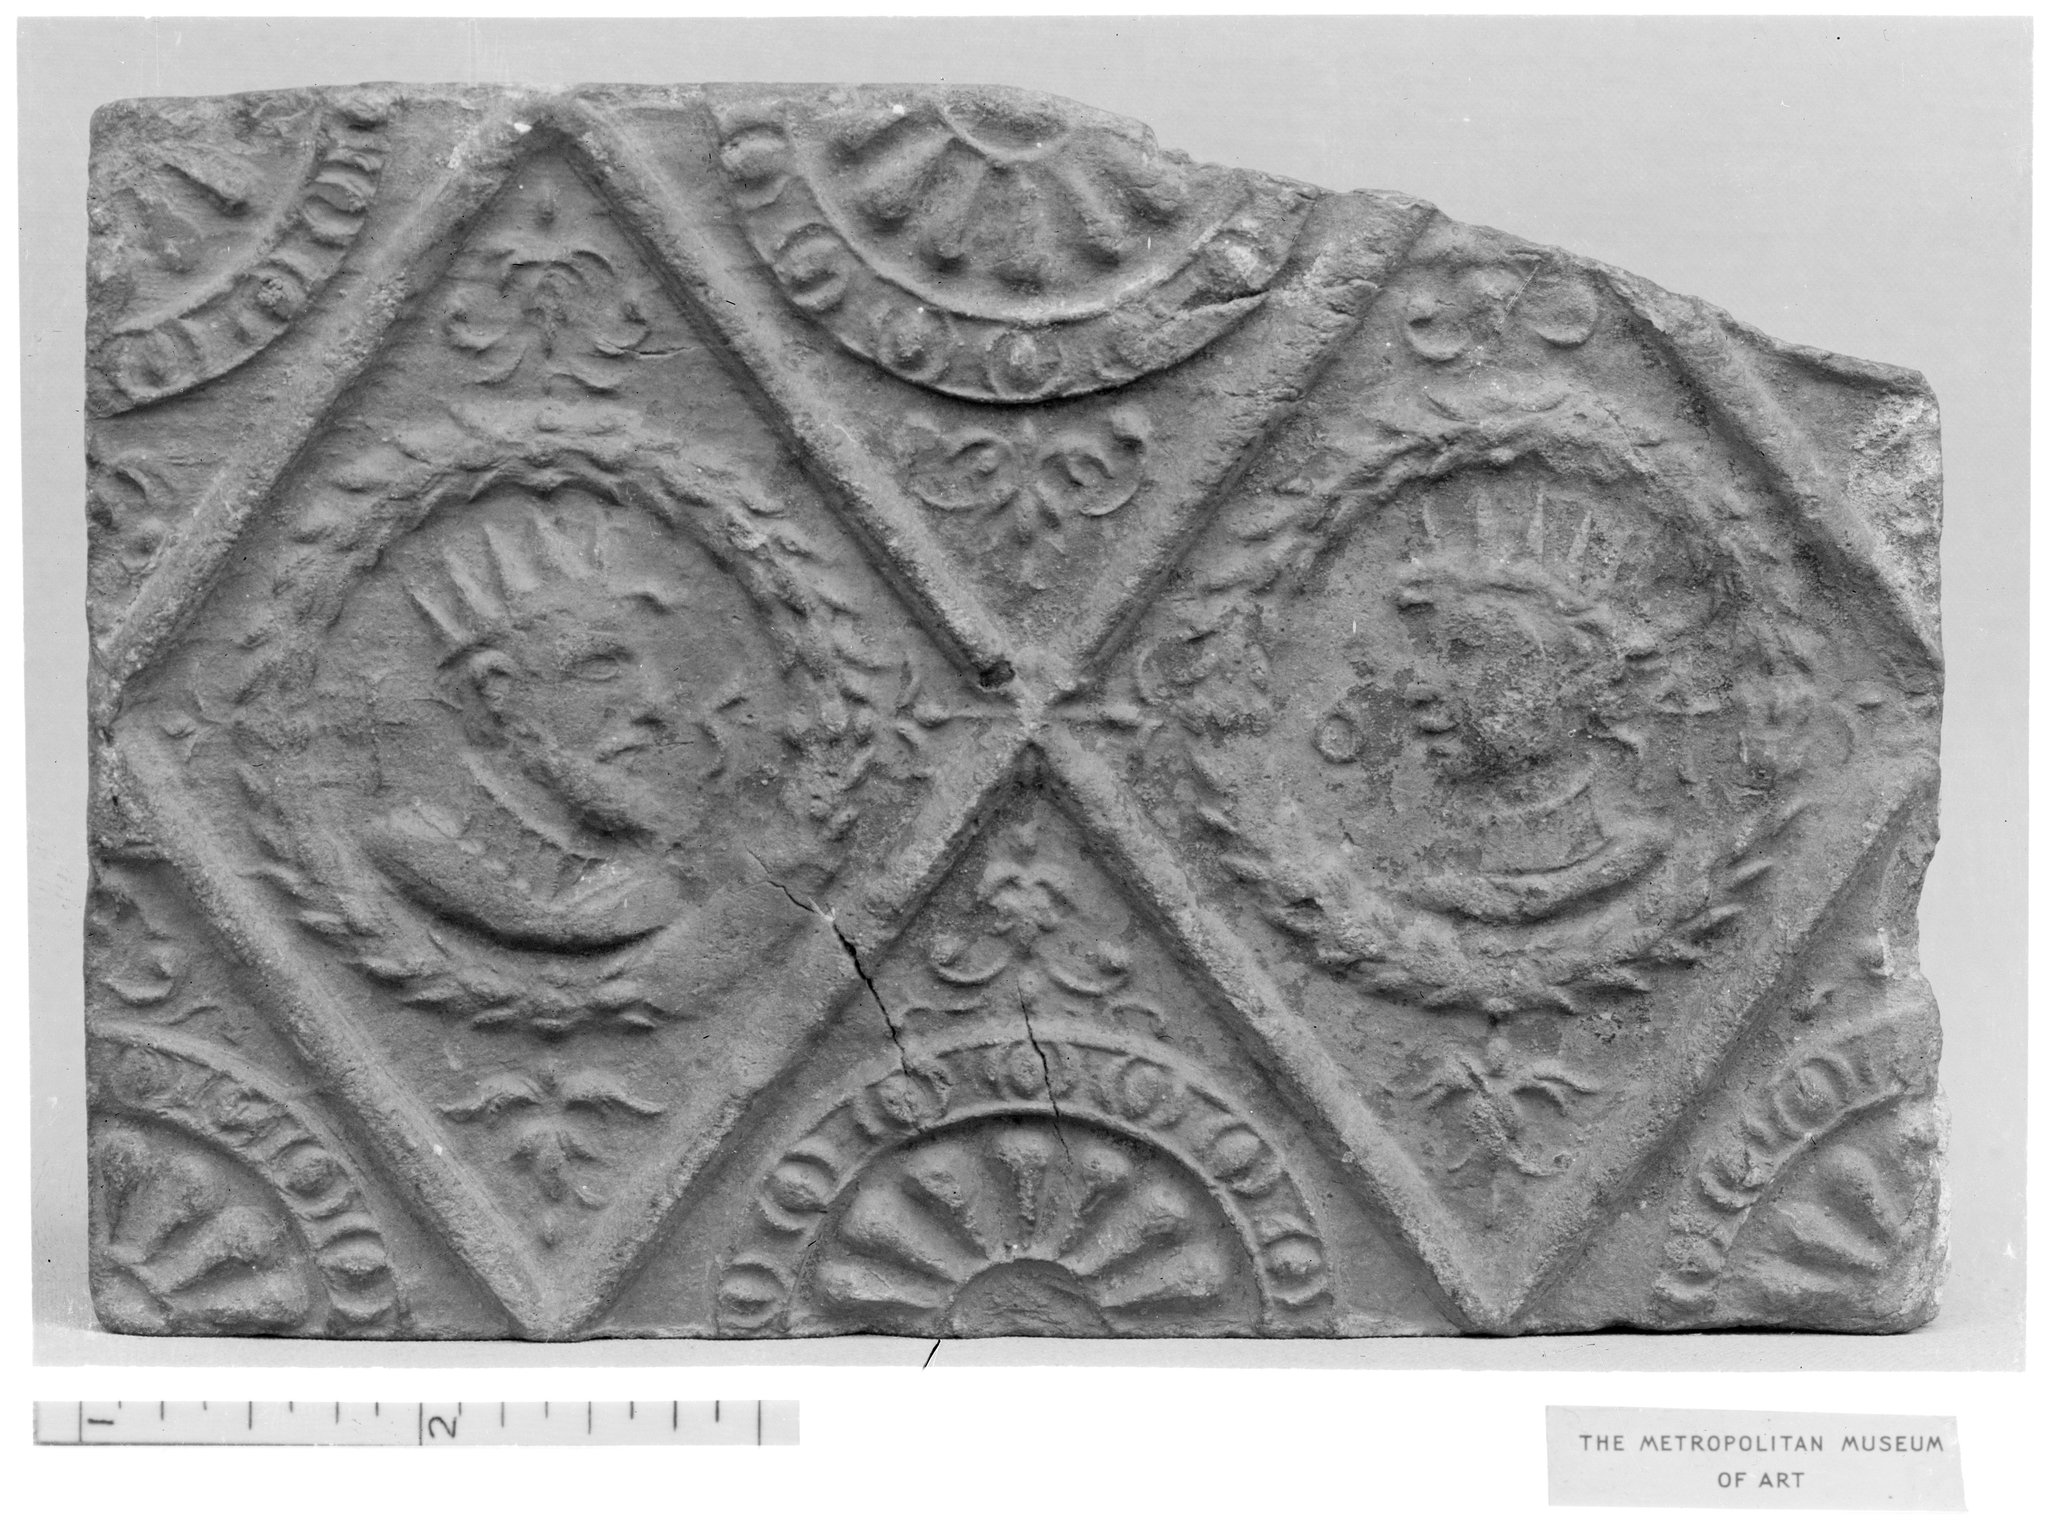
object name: tile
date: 1564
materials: terracotta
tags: profiles